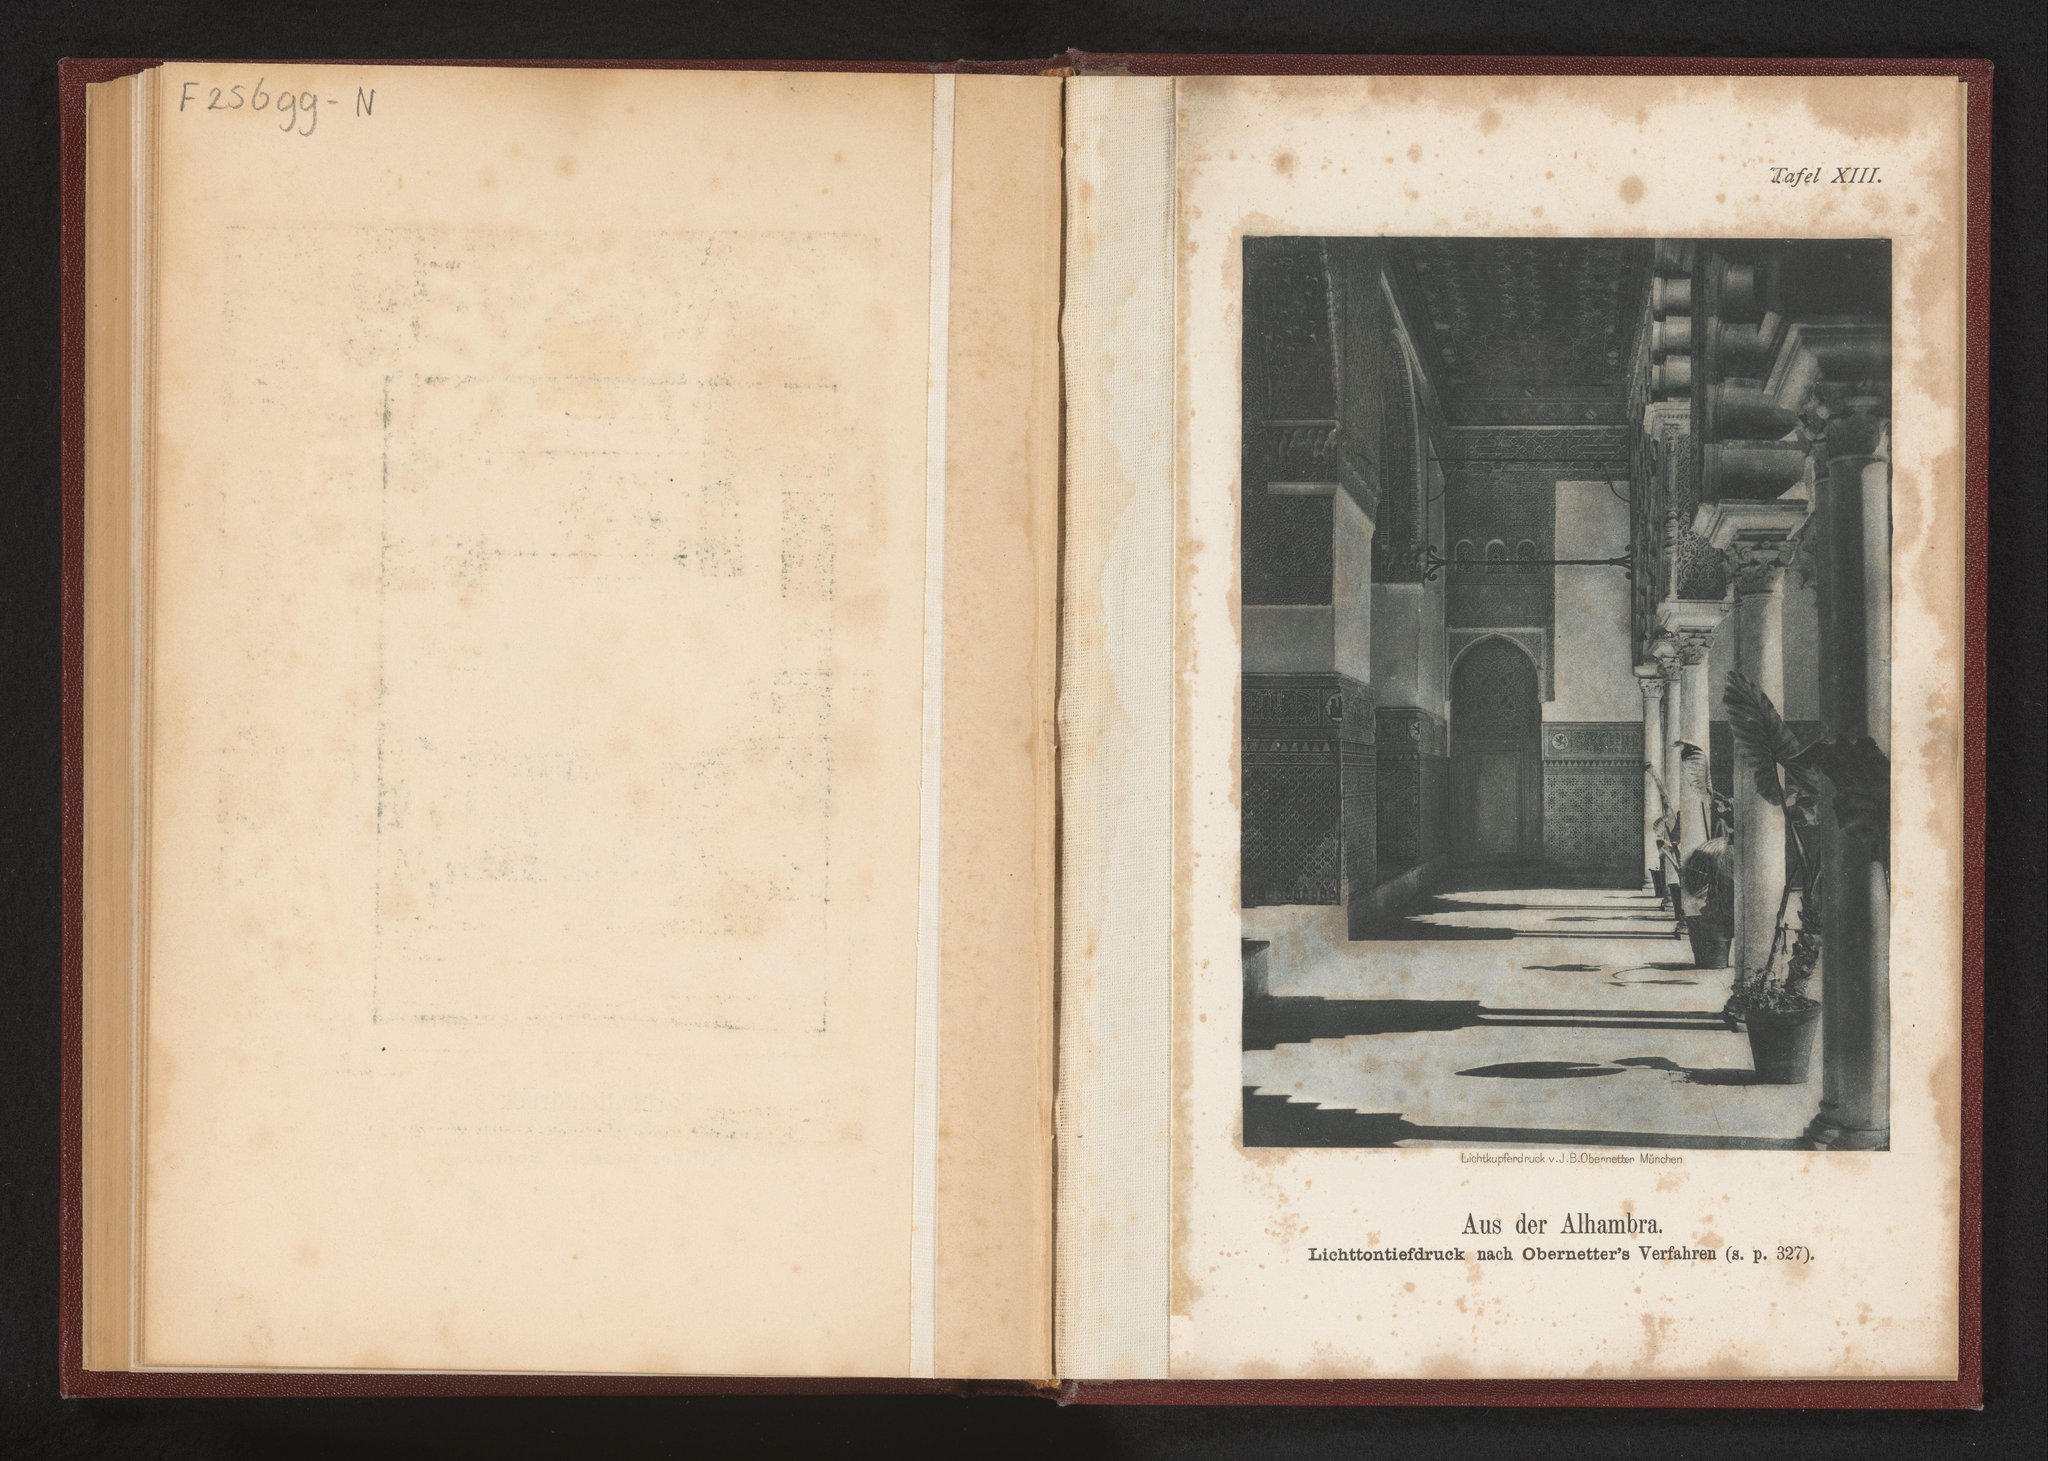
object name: photomechanical print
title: Interieur van het Alhambra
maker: johann baptist obernetter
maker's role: printer, publisher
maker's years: 1840-1887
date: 1885-1890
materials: paper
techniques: photoaquatint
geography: granada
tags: birds, interior ~ representation of a building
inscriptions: inscription: ‘Lichtkupferdruck v. J.B.Obernettte München/ Aus der Alhambra./ Lichttontiefdruck nach Obernetter's Verfahren (s. p. 327).’, number: ‘Tafel XIII.’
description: Prent op vierentwintigste ongenummerde pagina na pagina 351.